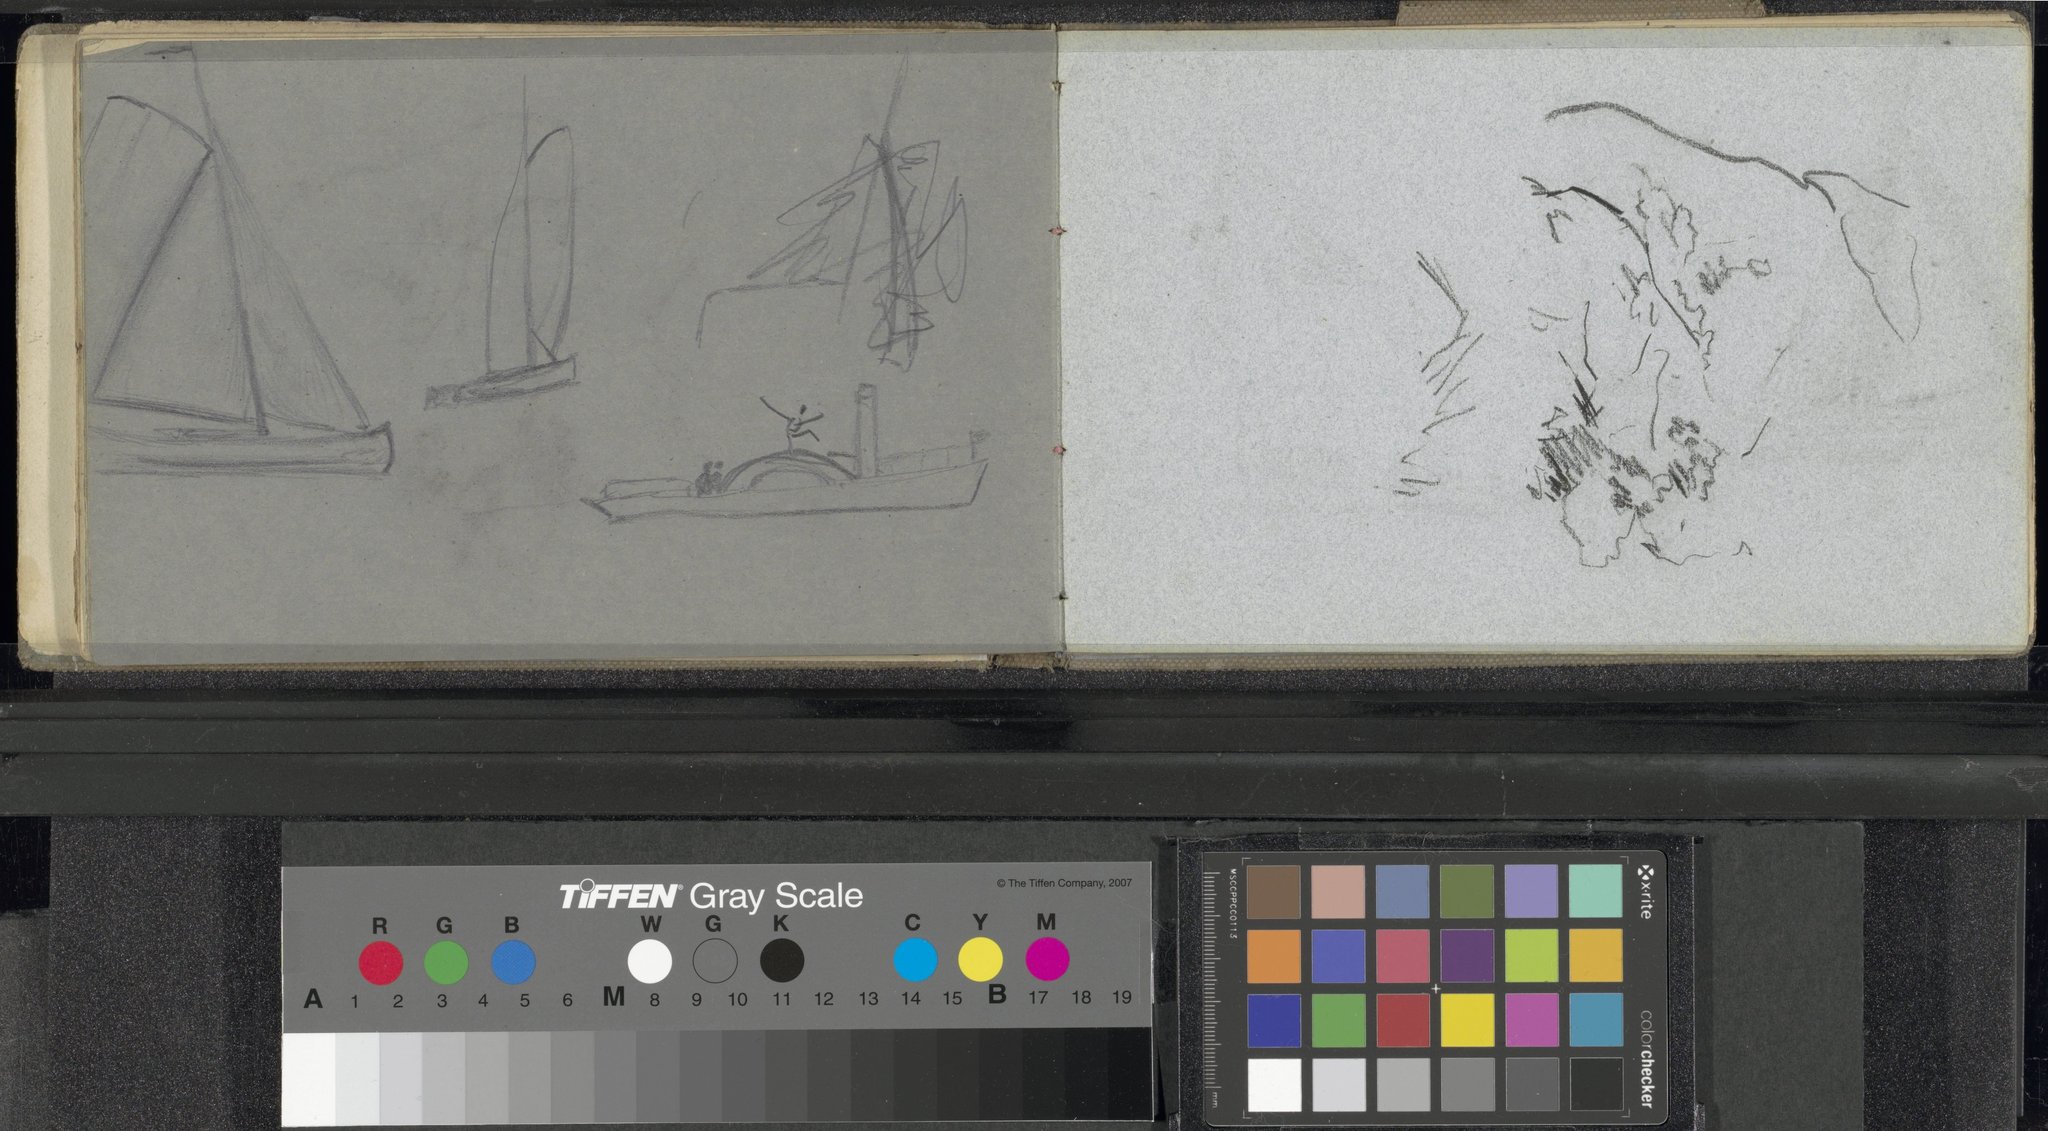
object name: sketchbook leaf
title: Studieblad met schepen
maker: louis apol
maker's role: draughtsman, painter, print maker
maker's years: 1850-1936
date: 1880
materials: paper, pencil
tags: ships (in general)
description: Blad 25 verso uit een schetsboek met 38 bladen betekend tijdens de expeditie naar Nova Zembla in 1880.